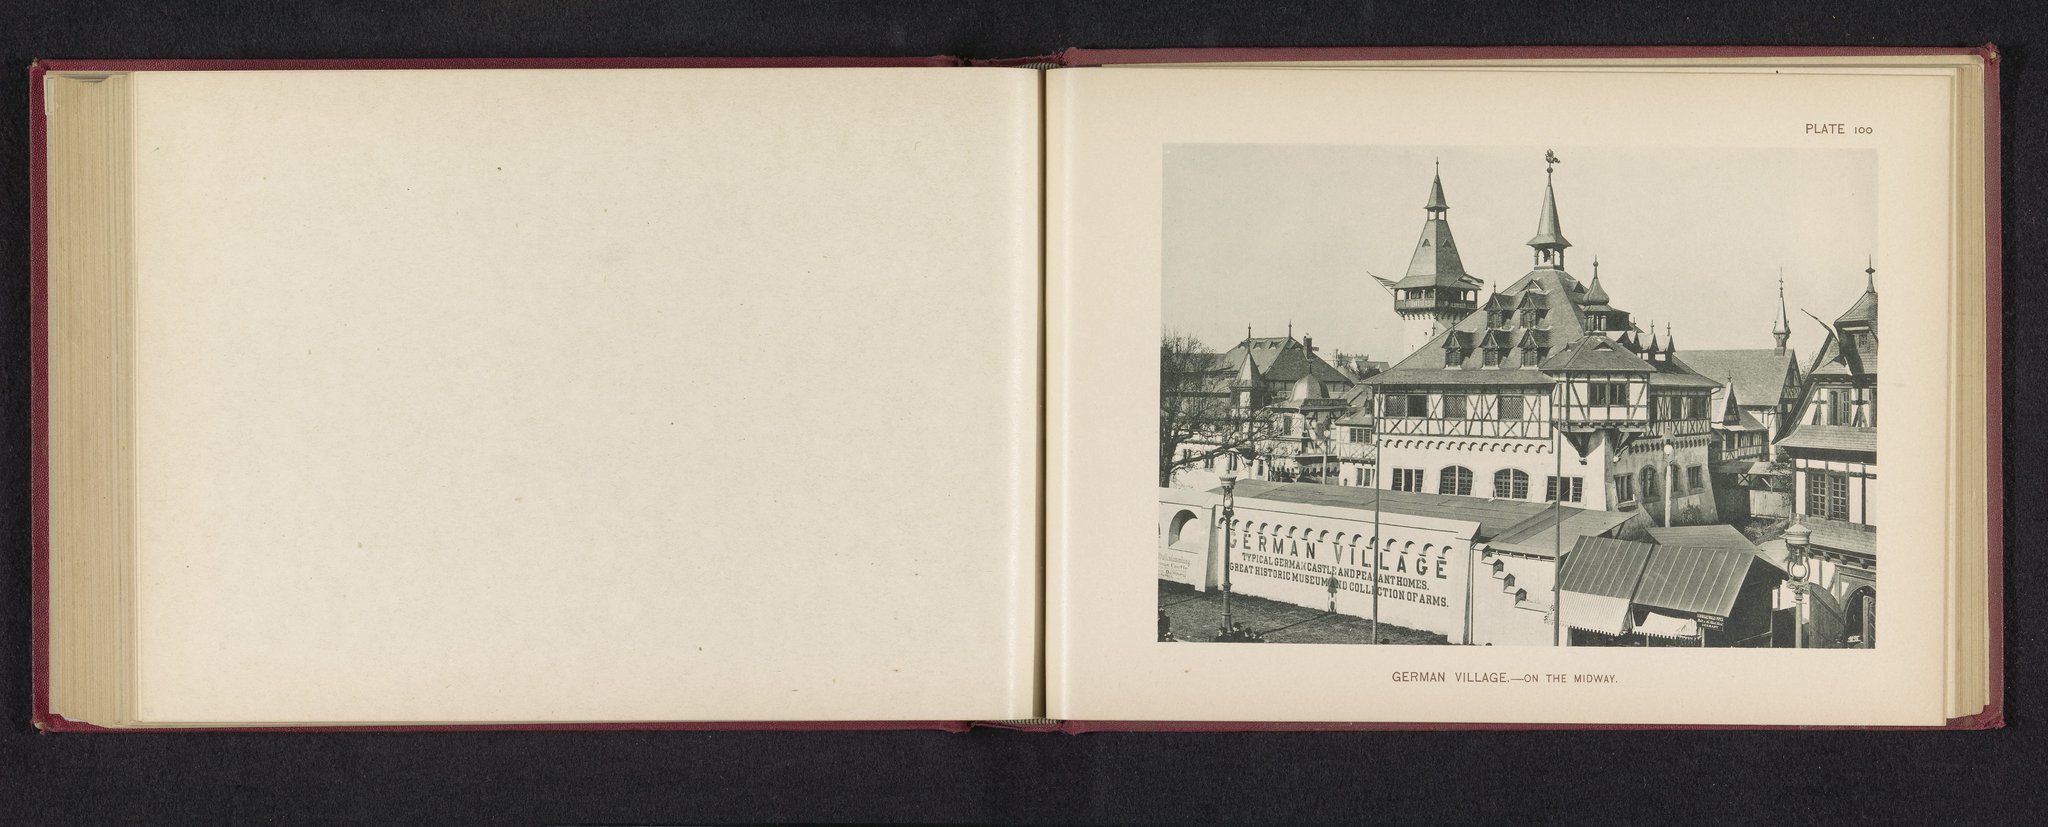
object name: photomechanical print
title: German Village.- on the Midway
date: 1893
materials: paper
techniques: photograph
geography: chicago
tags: world fair, world exhibition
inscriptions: number: ‘Plate 100’